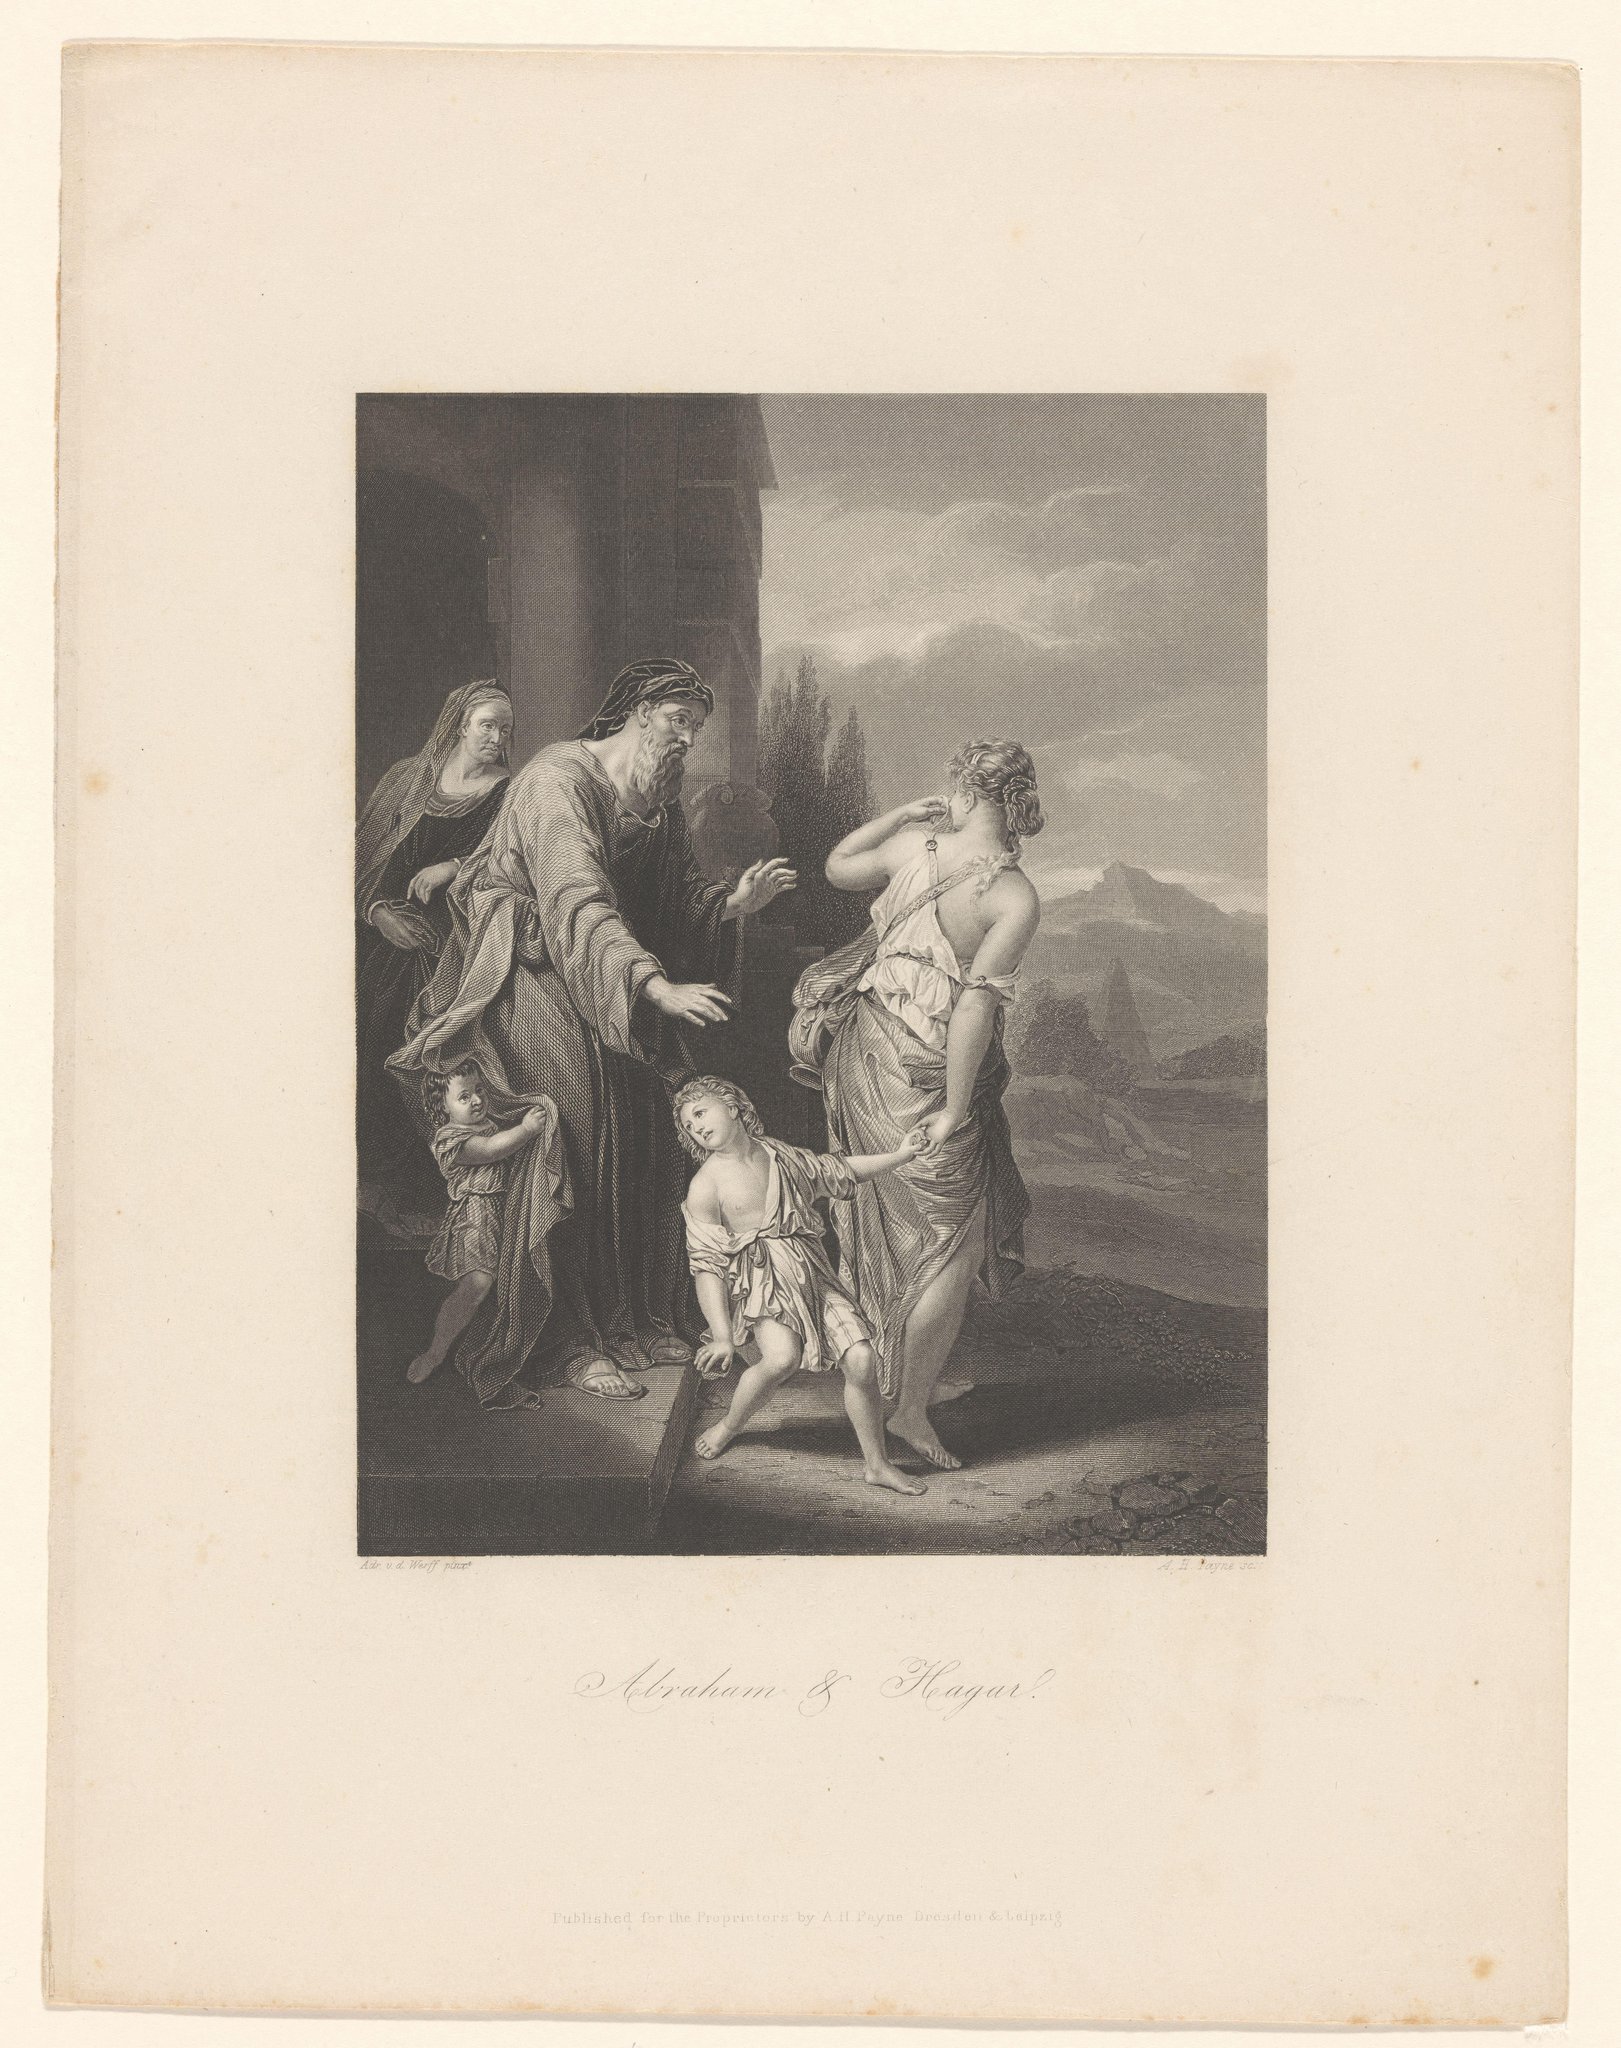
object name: print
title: Abraham & Hagar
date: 1822-1902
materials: paper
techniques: engraving, etching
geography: london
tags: the banishment of hagar and ishmael (genesis 21:9-21)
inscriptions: collector's mark: Lugt 2228